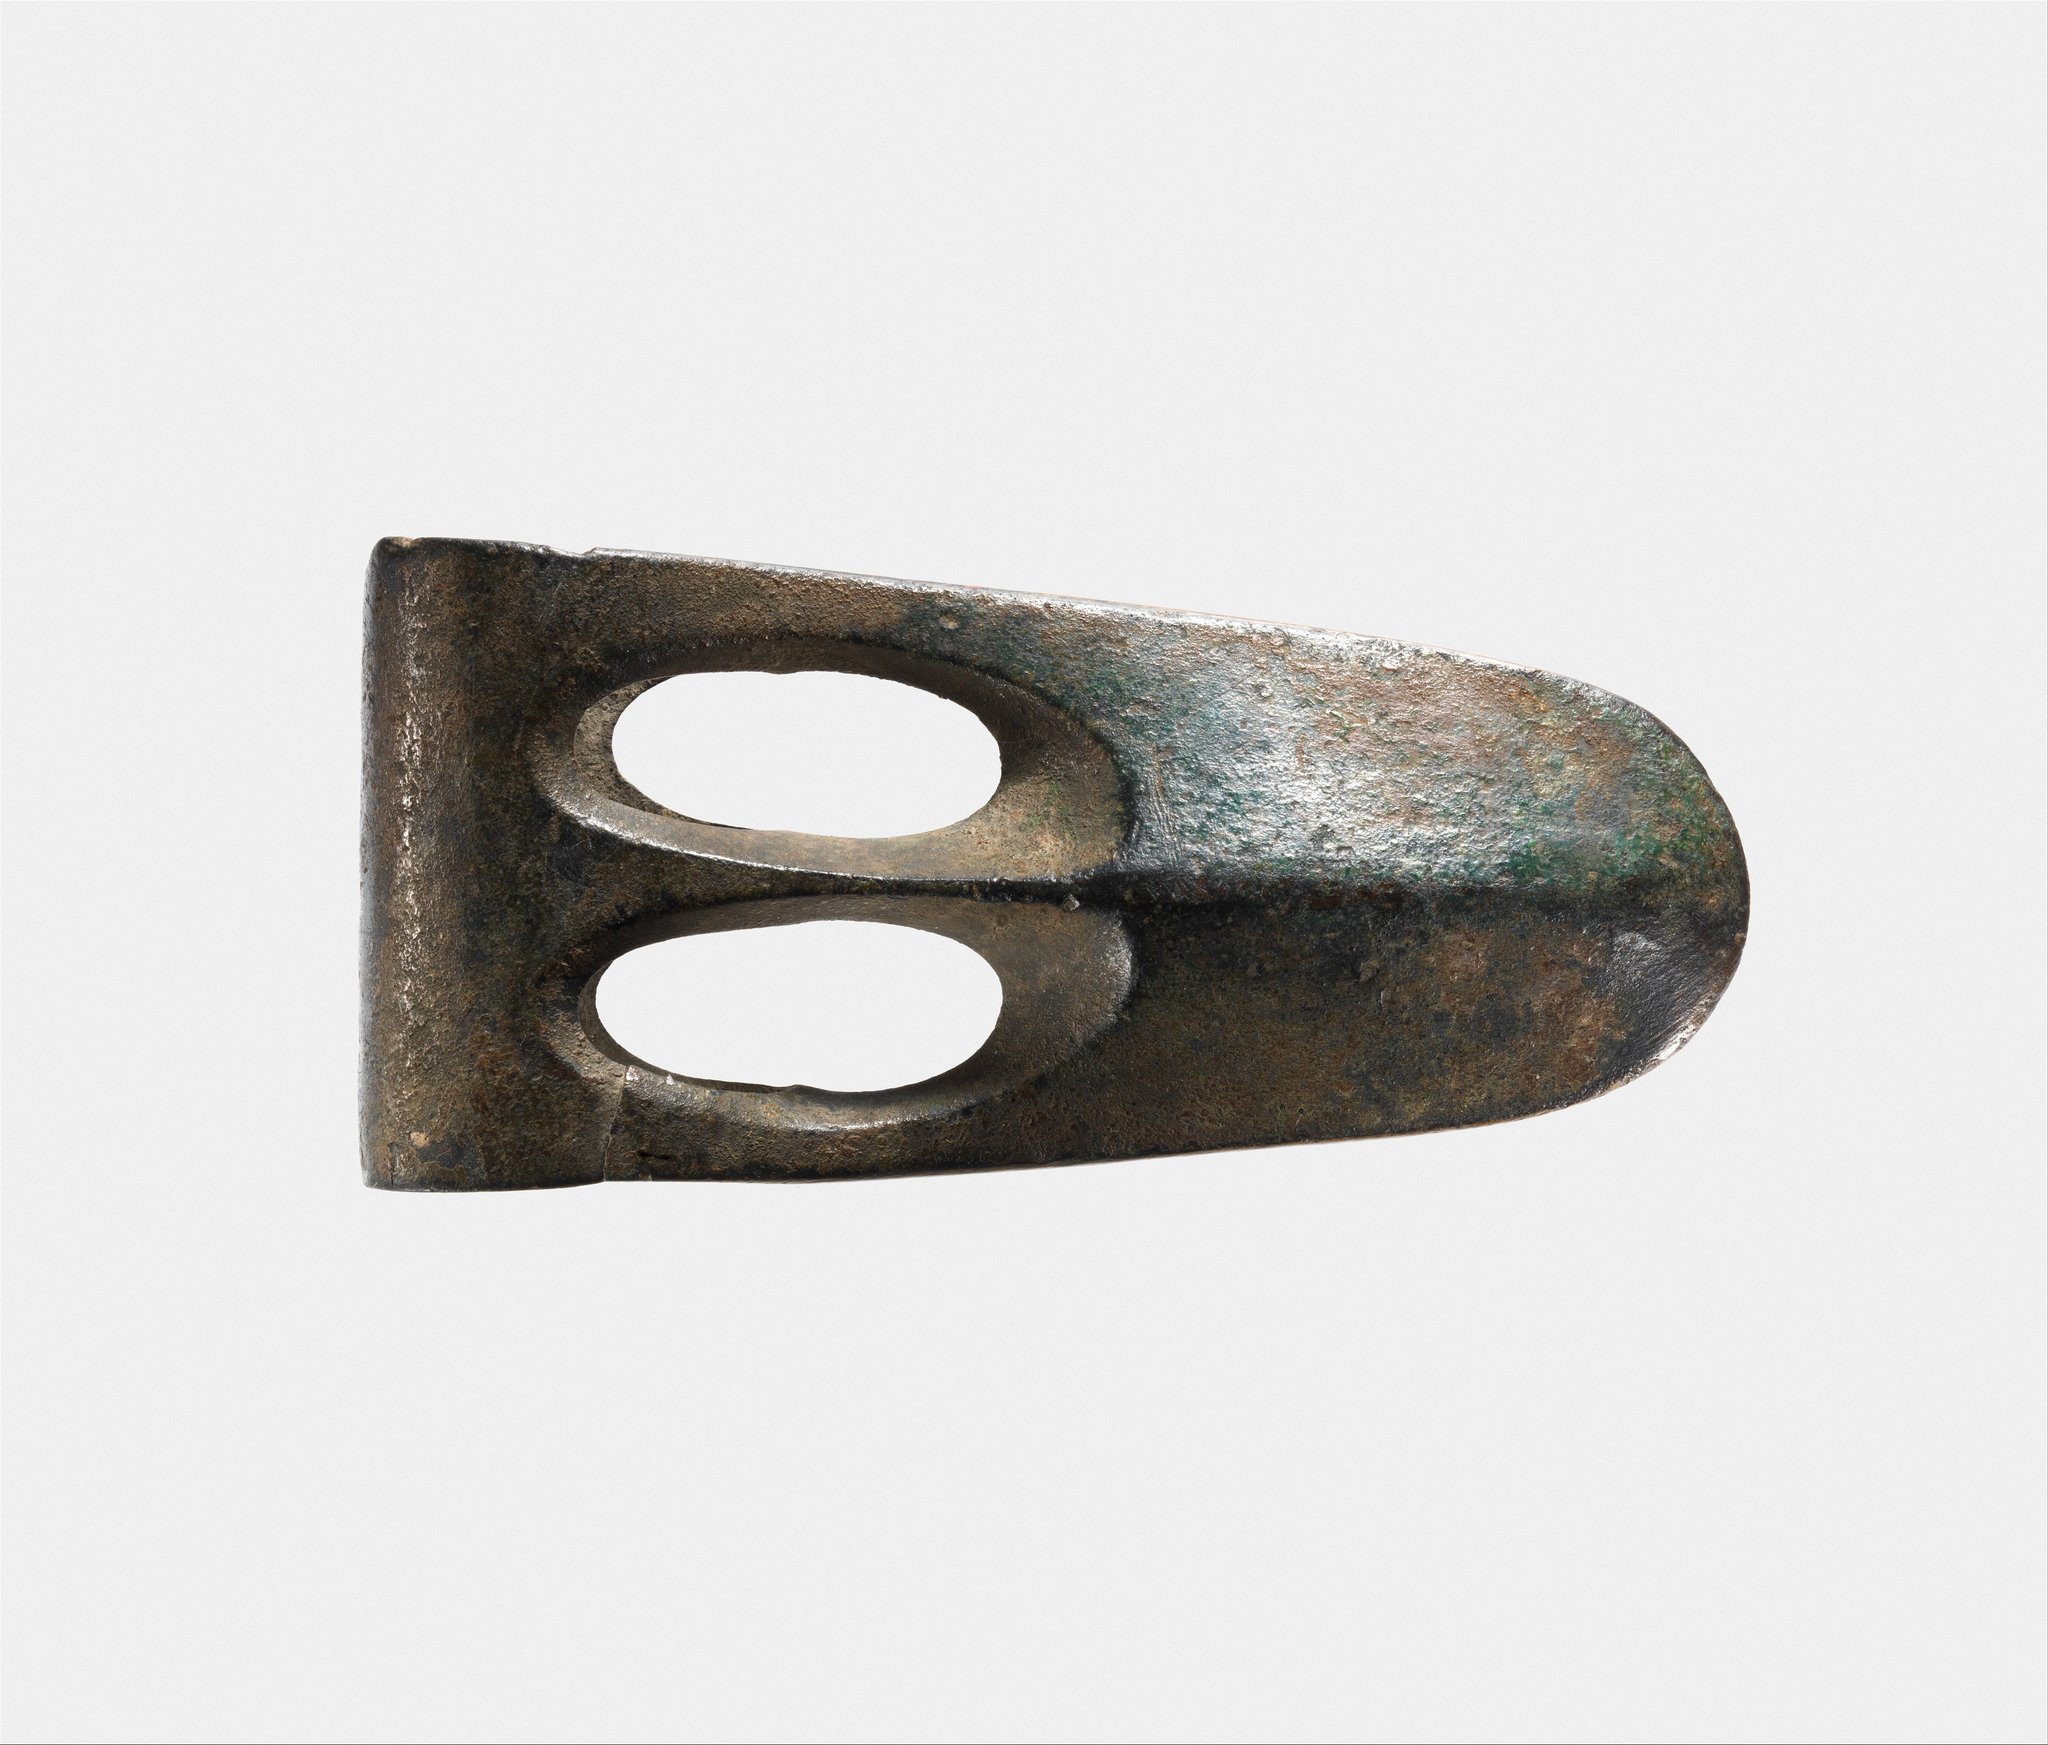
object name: ax head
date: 1981-1550 BCE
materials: bronze, copper alloy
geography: egypt